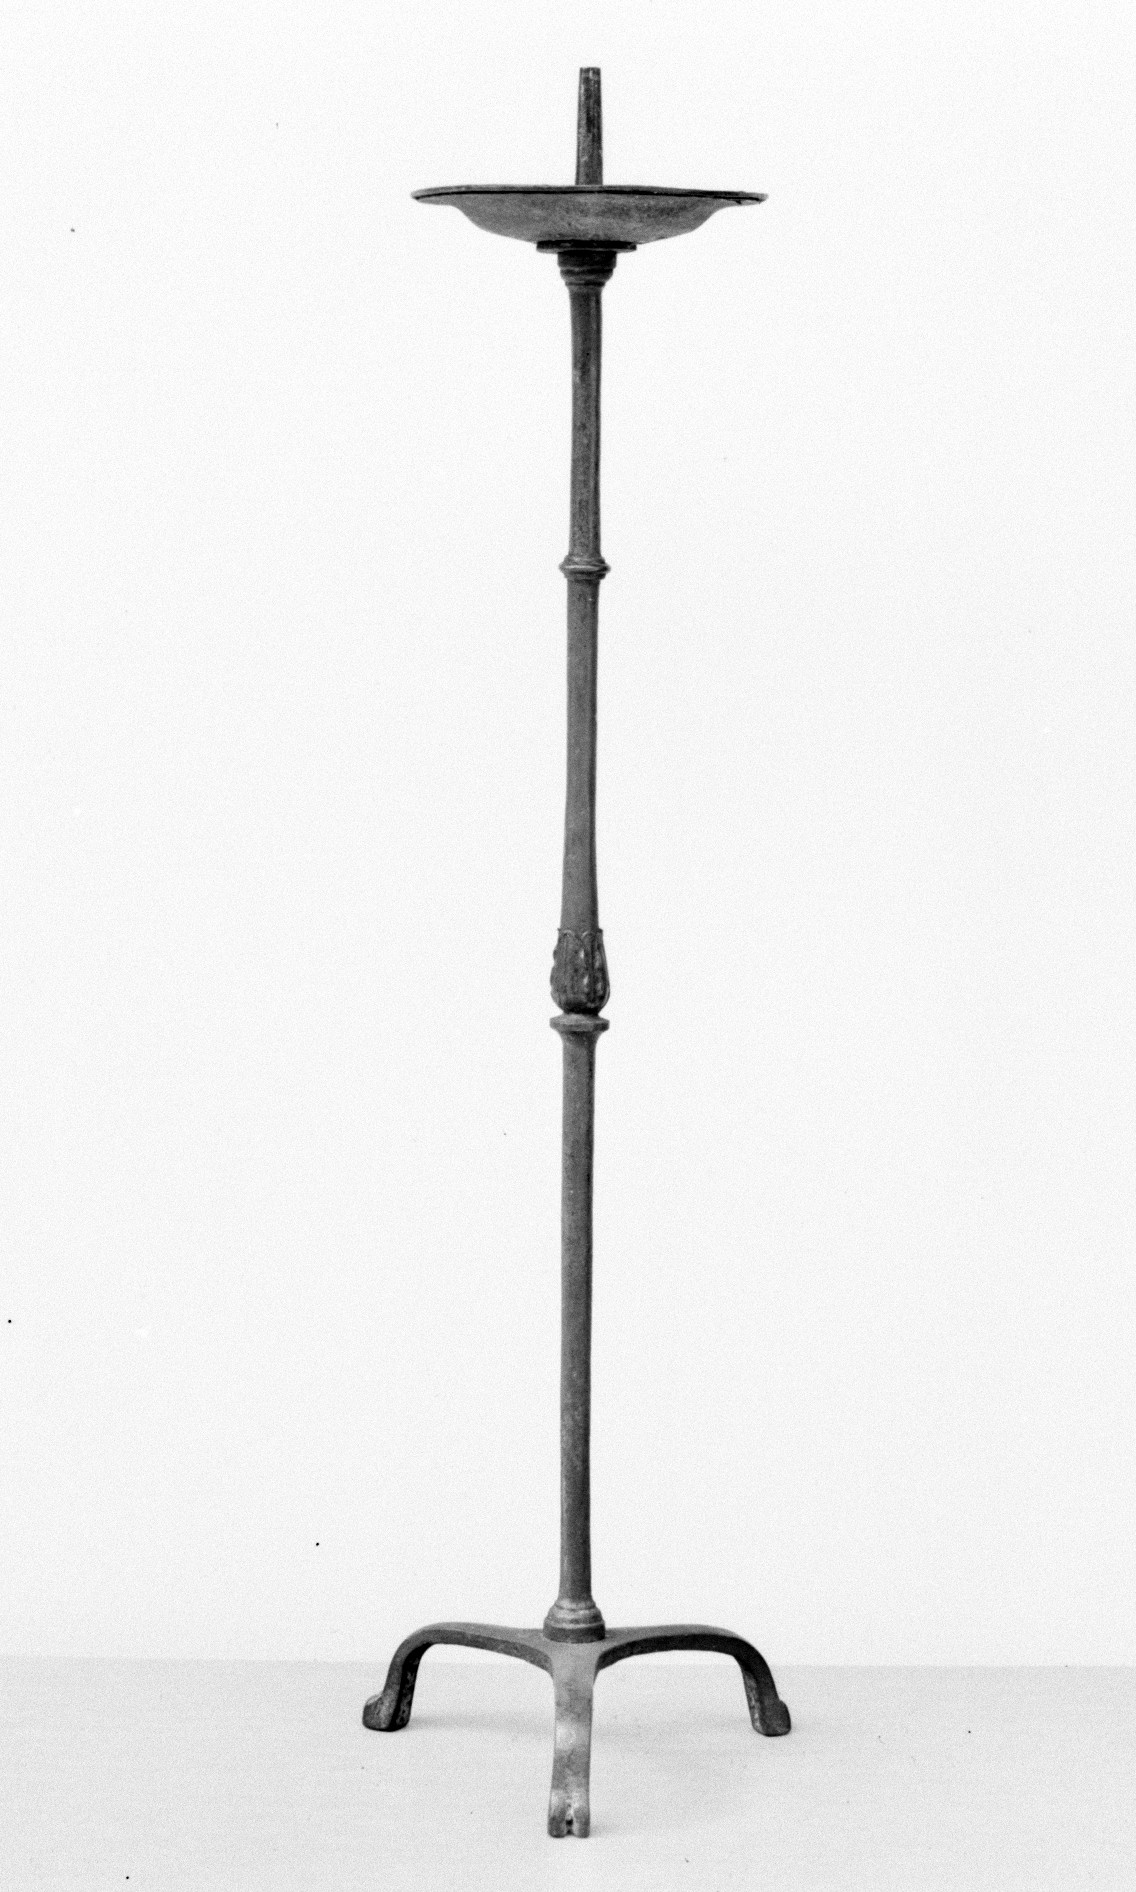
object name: candelabrum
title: Pair of candelabra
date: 1501-1600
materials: iron